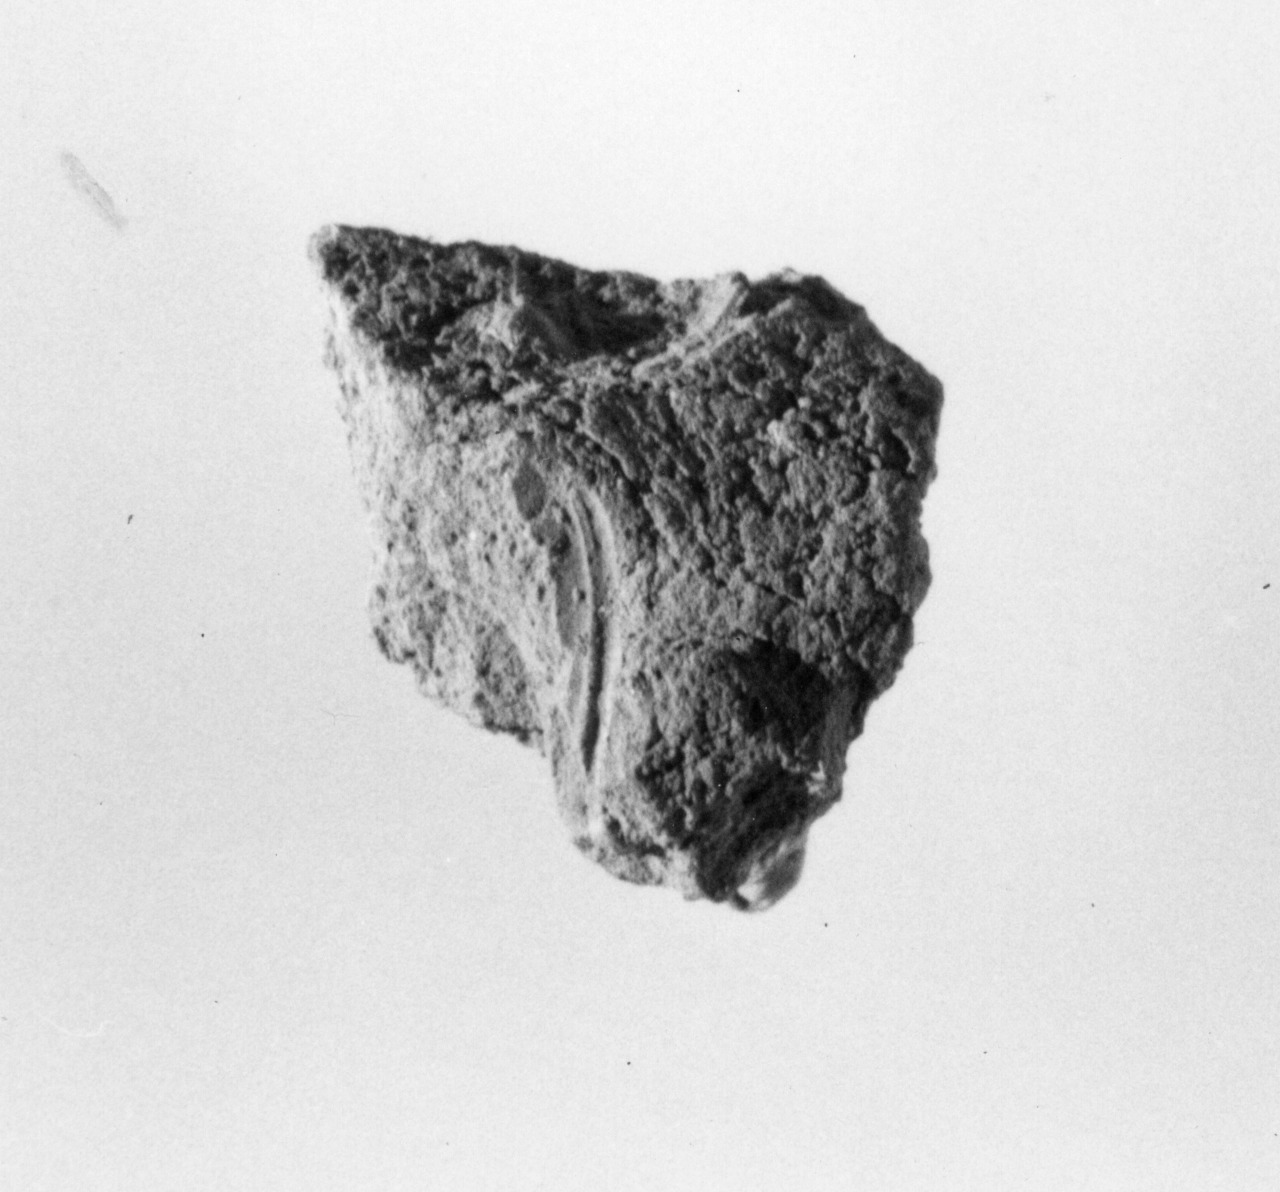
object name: sealing, no type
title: Document Sealing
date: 1390-1352 BCE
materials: mud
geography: egypt